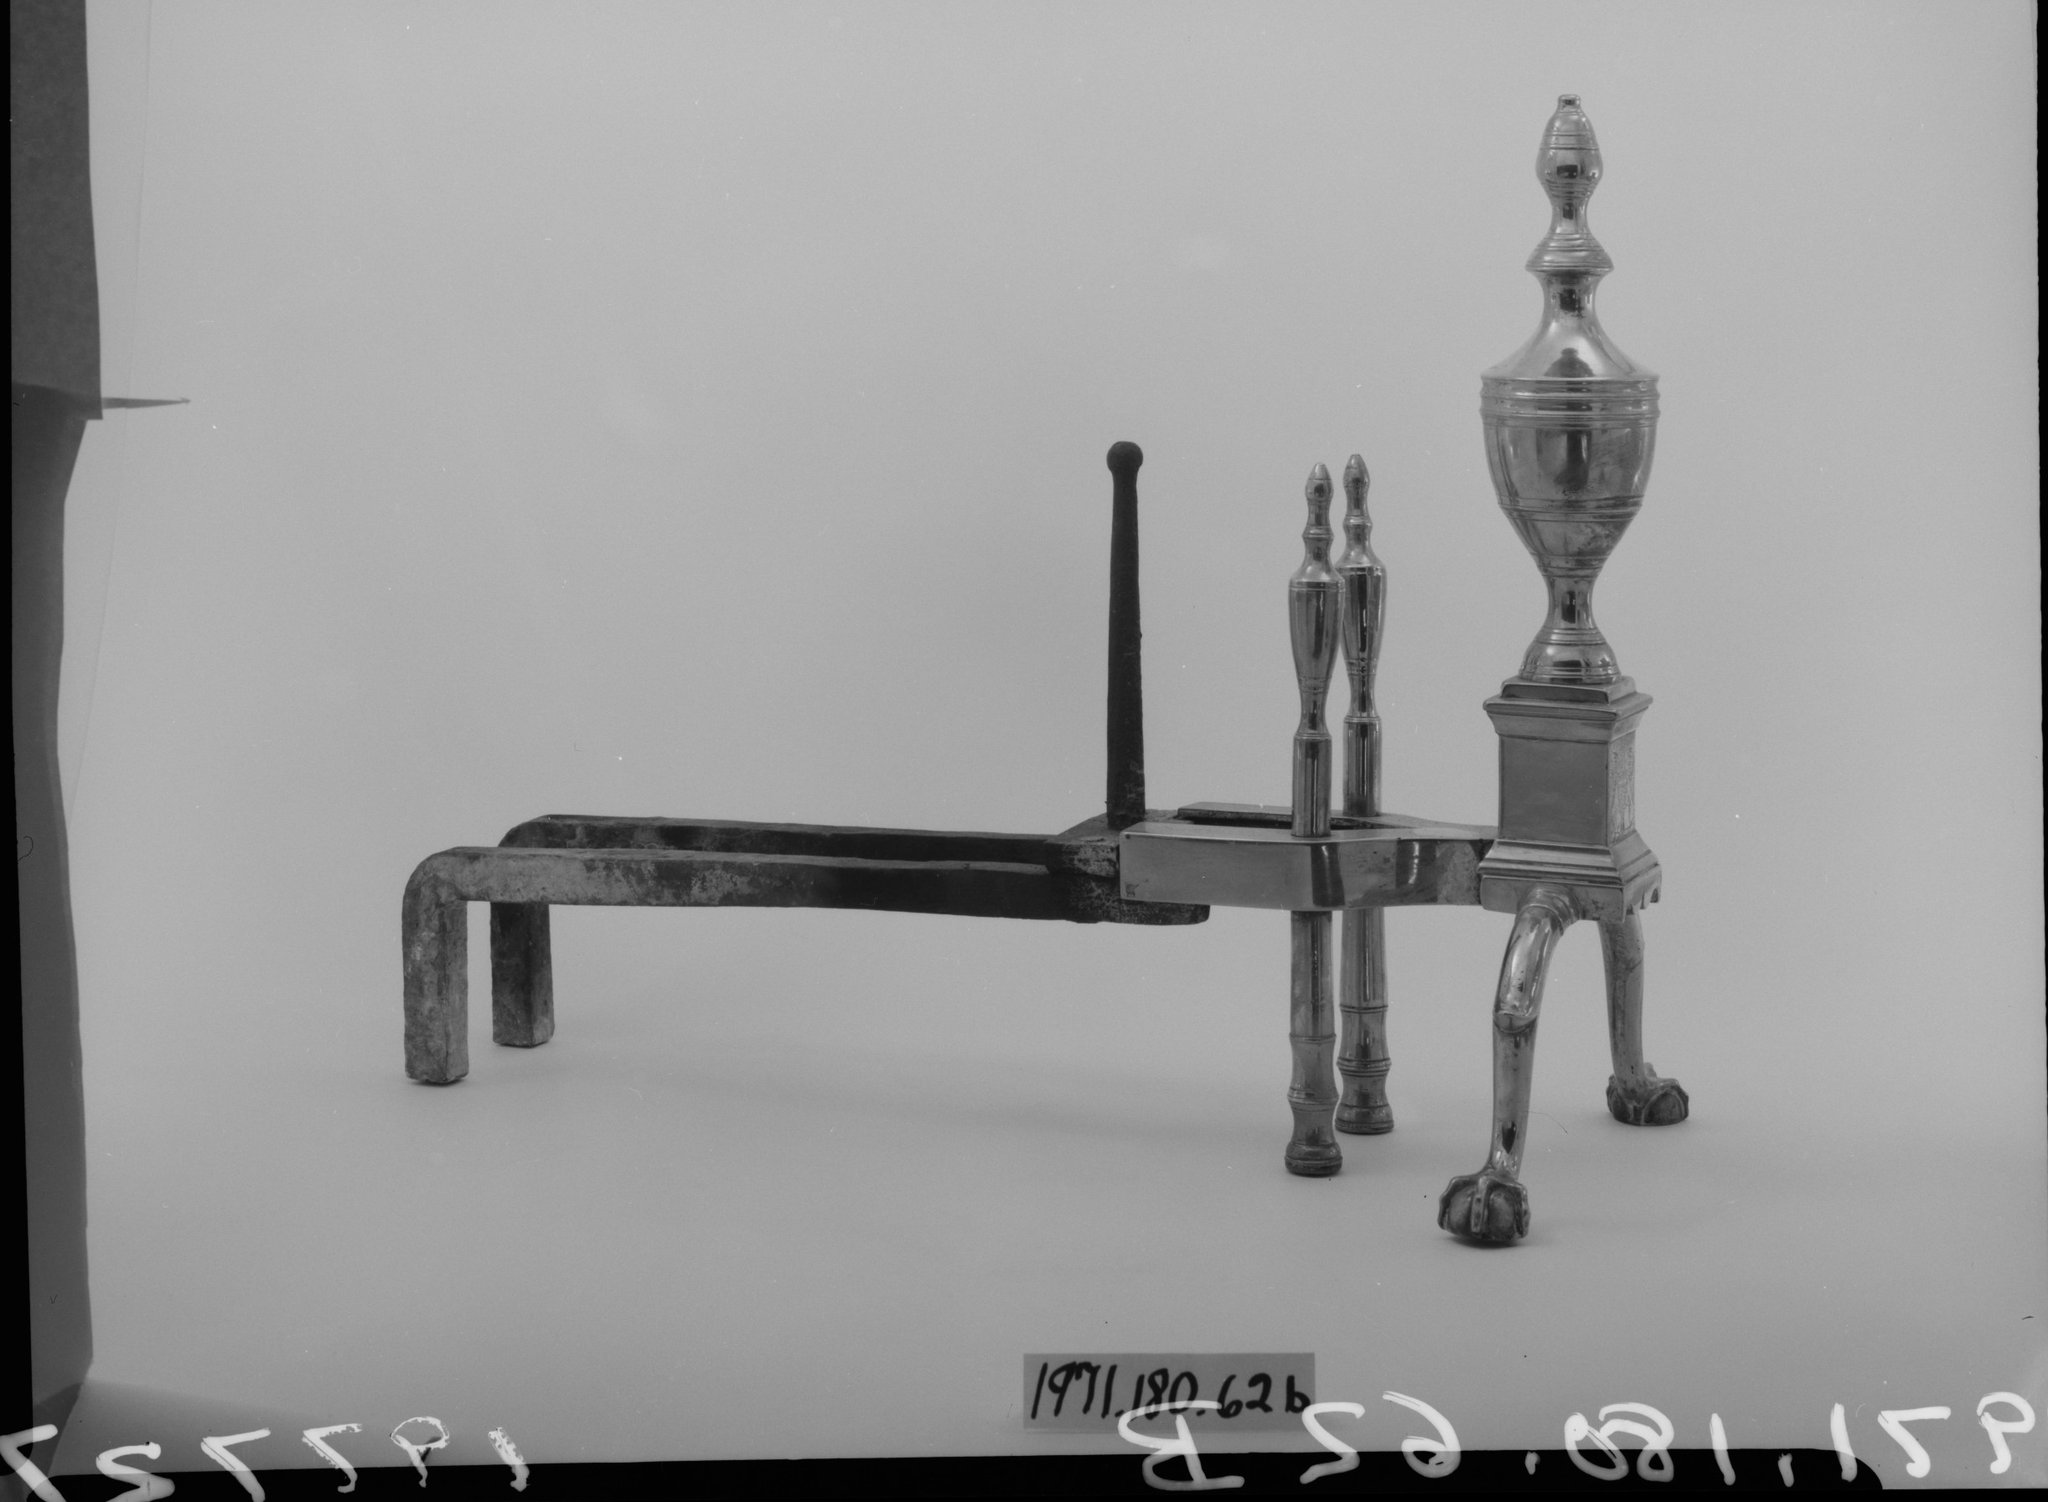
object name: andiron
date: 1790-1820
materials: brass, iron